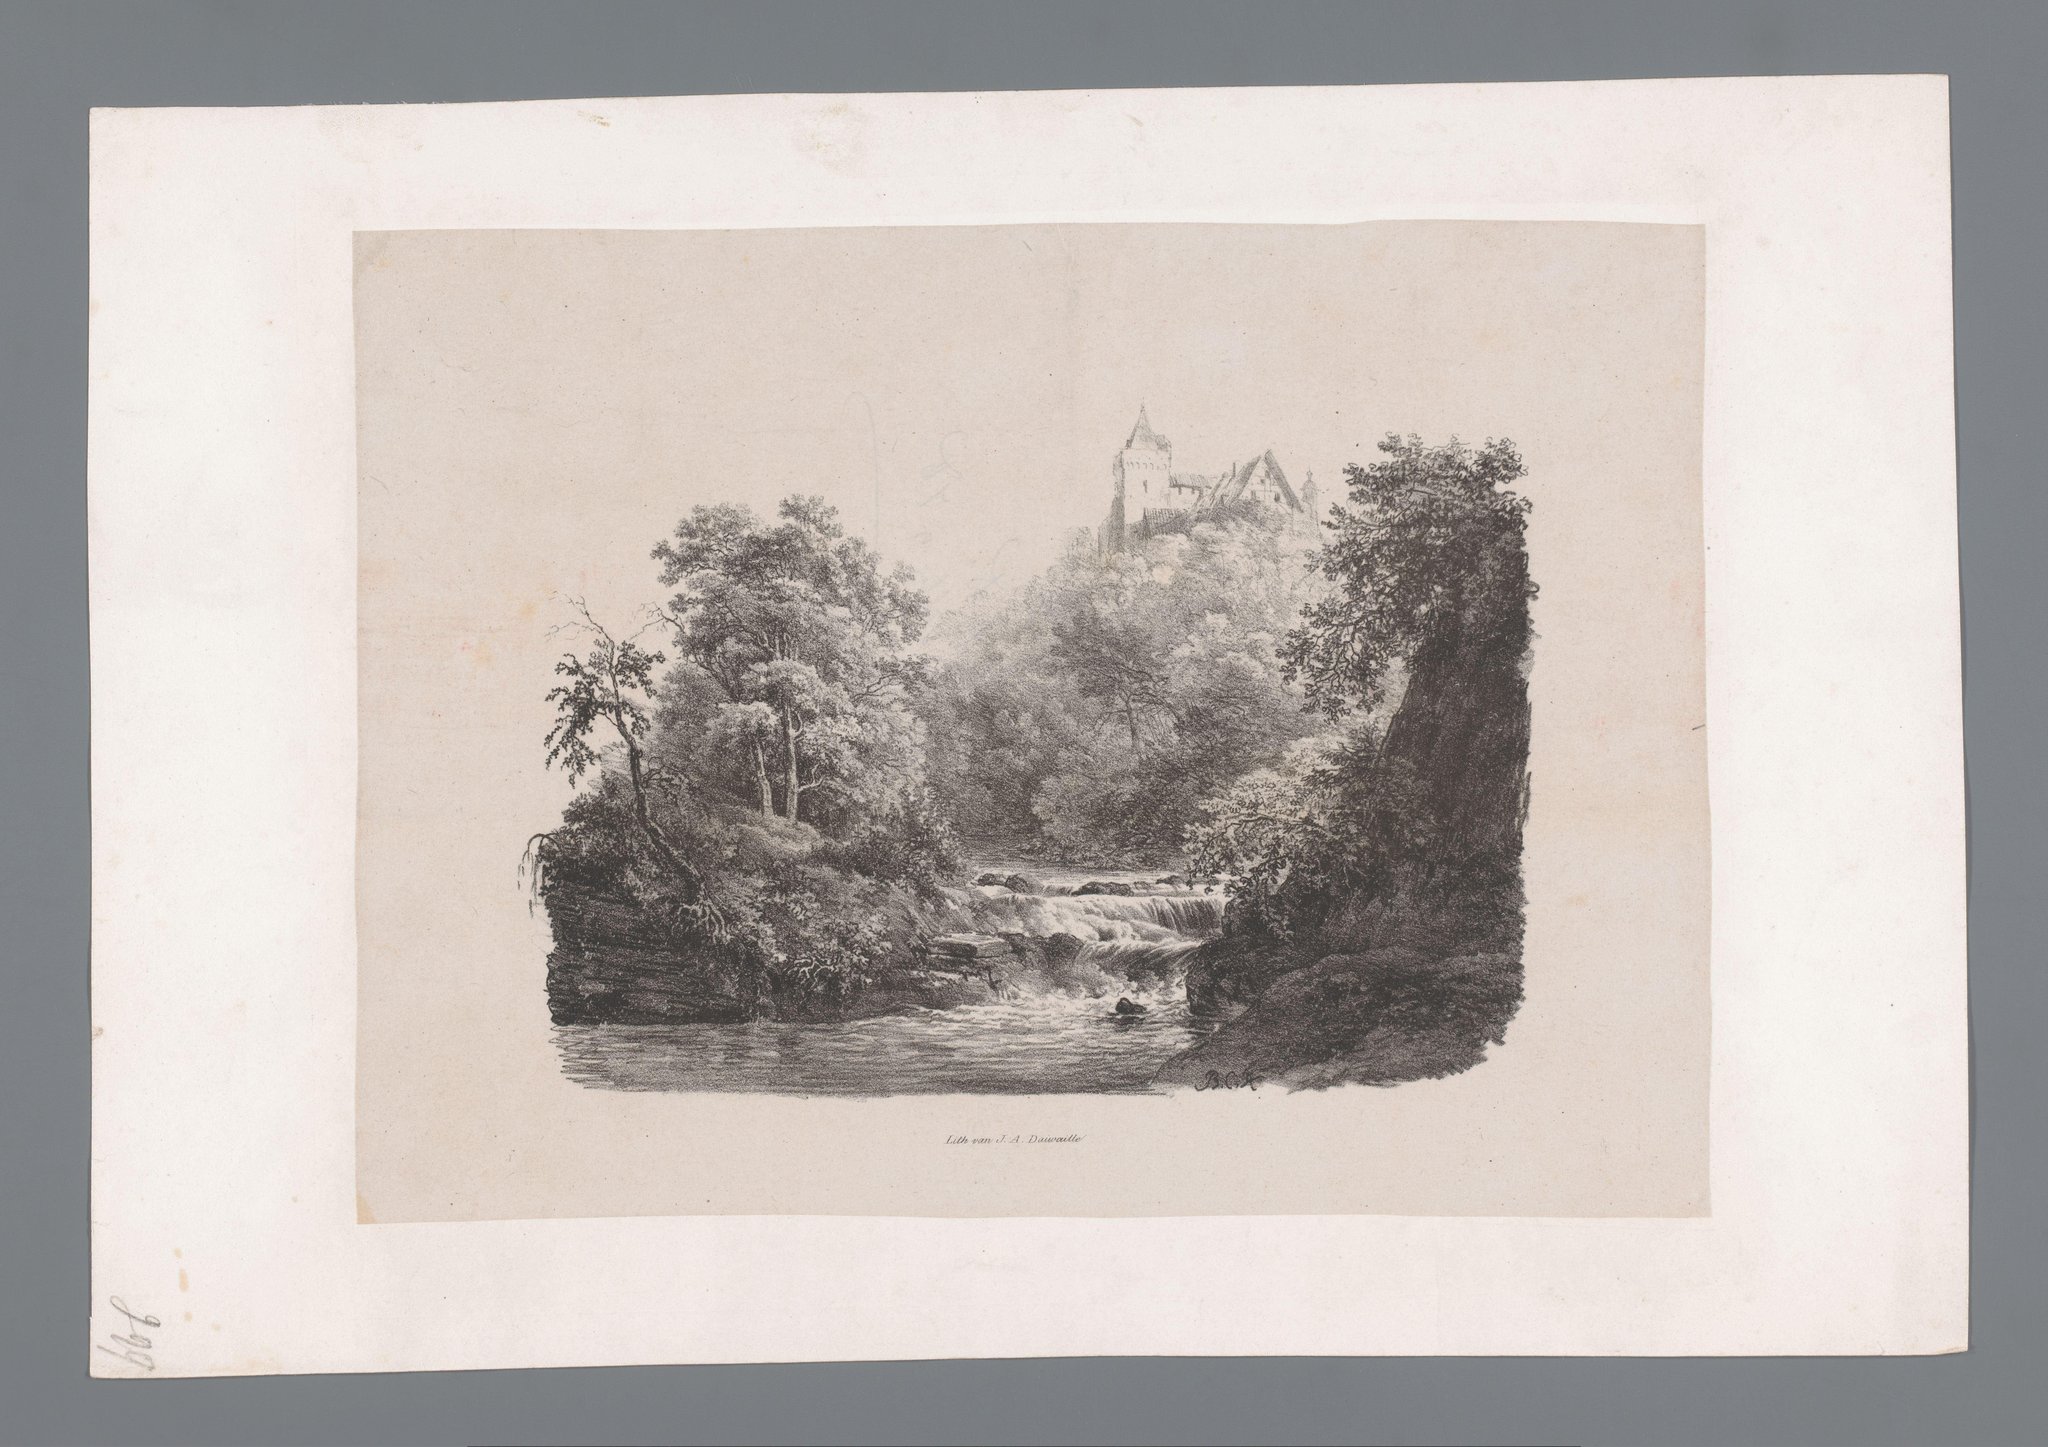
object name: print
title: Landschap met rivier en kasteel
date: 1829-1830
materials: paper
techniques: lithograph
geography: amsterdam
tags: rapids, castle, river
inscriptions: collector's mark: Lugt 2228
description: In 1829 en 1830 gaf Koekkoek, samen met Daiwaille, zes cahiers uit met ieder zes prenten getiteld Landschapstudiën. Deze werden gebruikt in het tekenonderwijs. Vijftien jaar later werd deze reeks, in een andere samenstelling nogmaals uitgegeven door Meyer en Comp in Amsterdam. Zie: De Bruyn Kops, 1963.